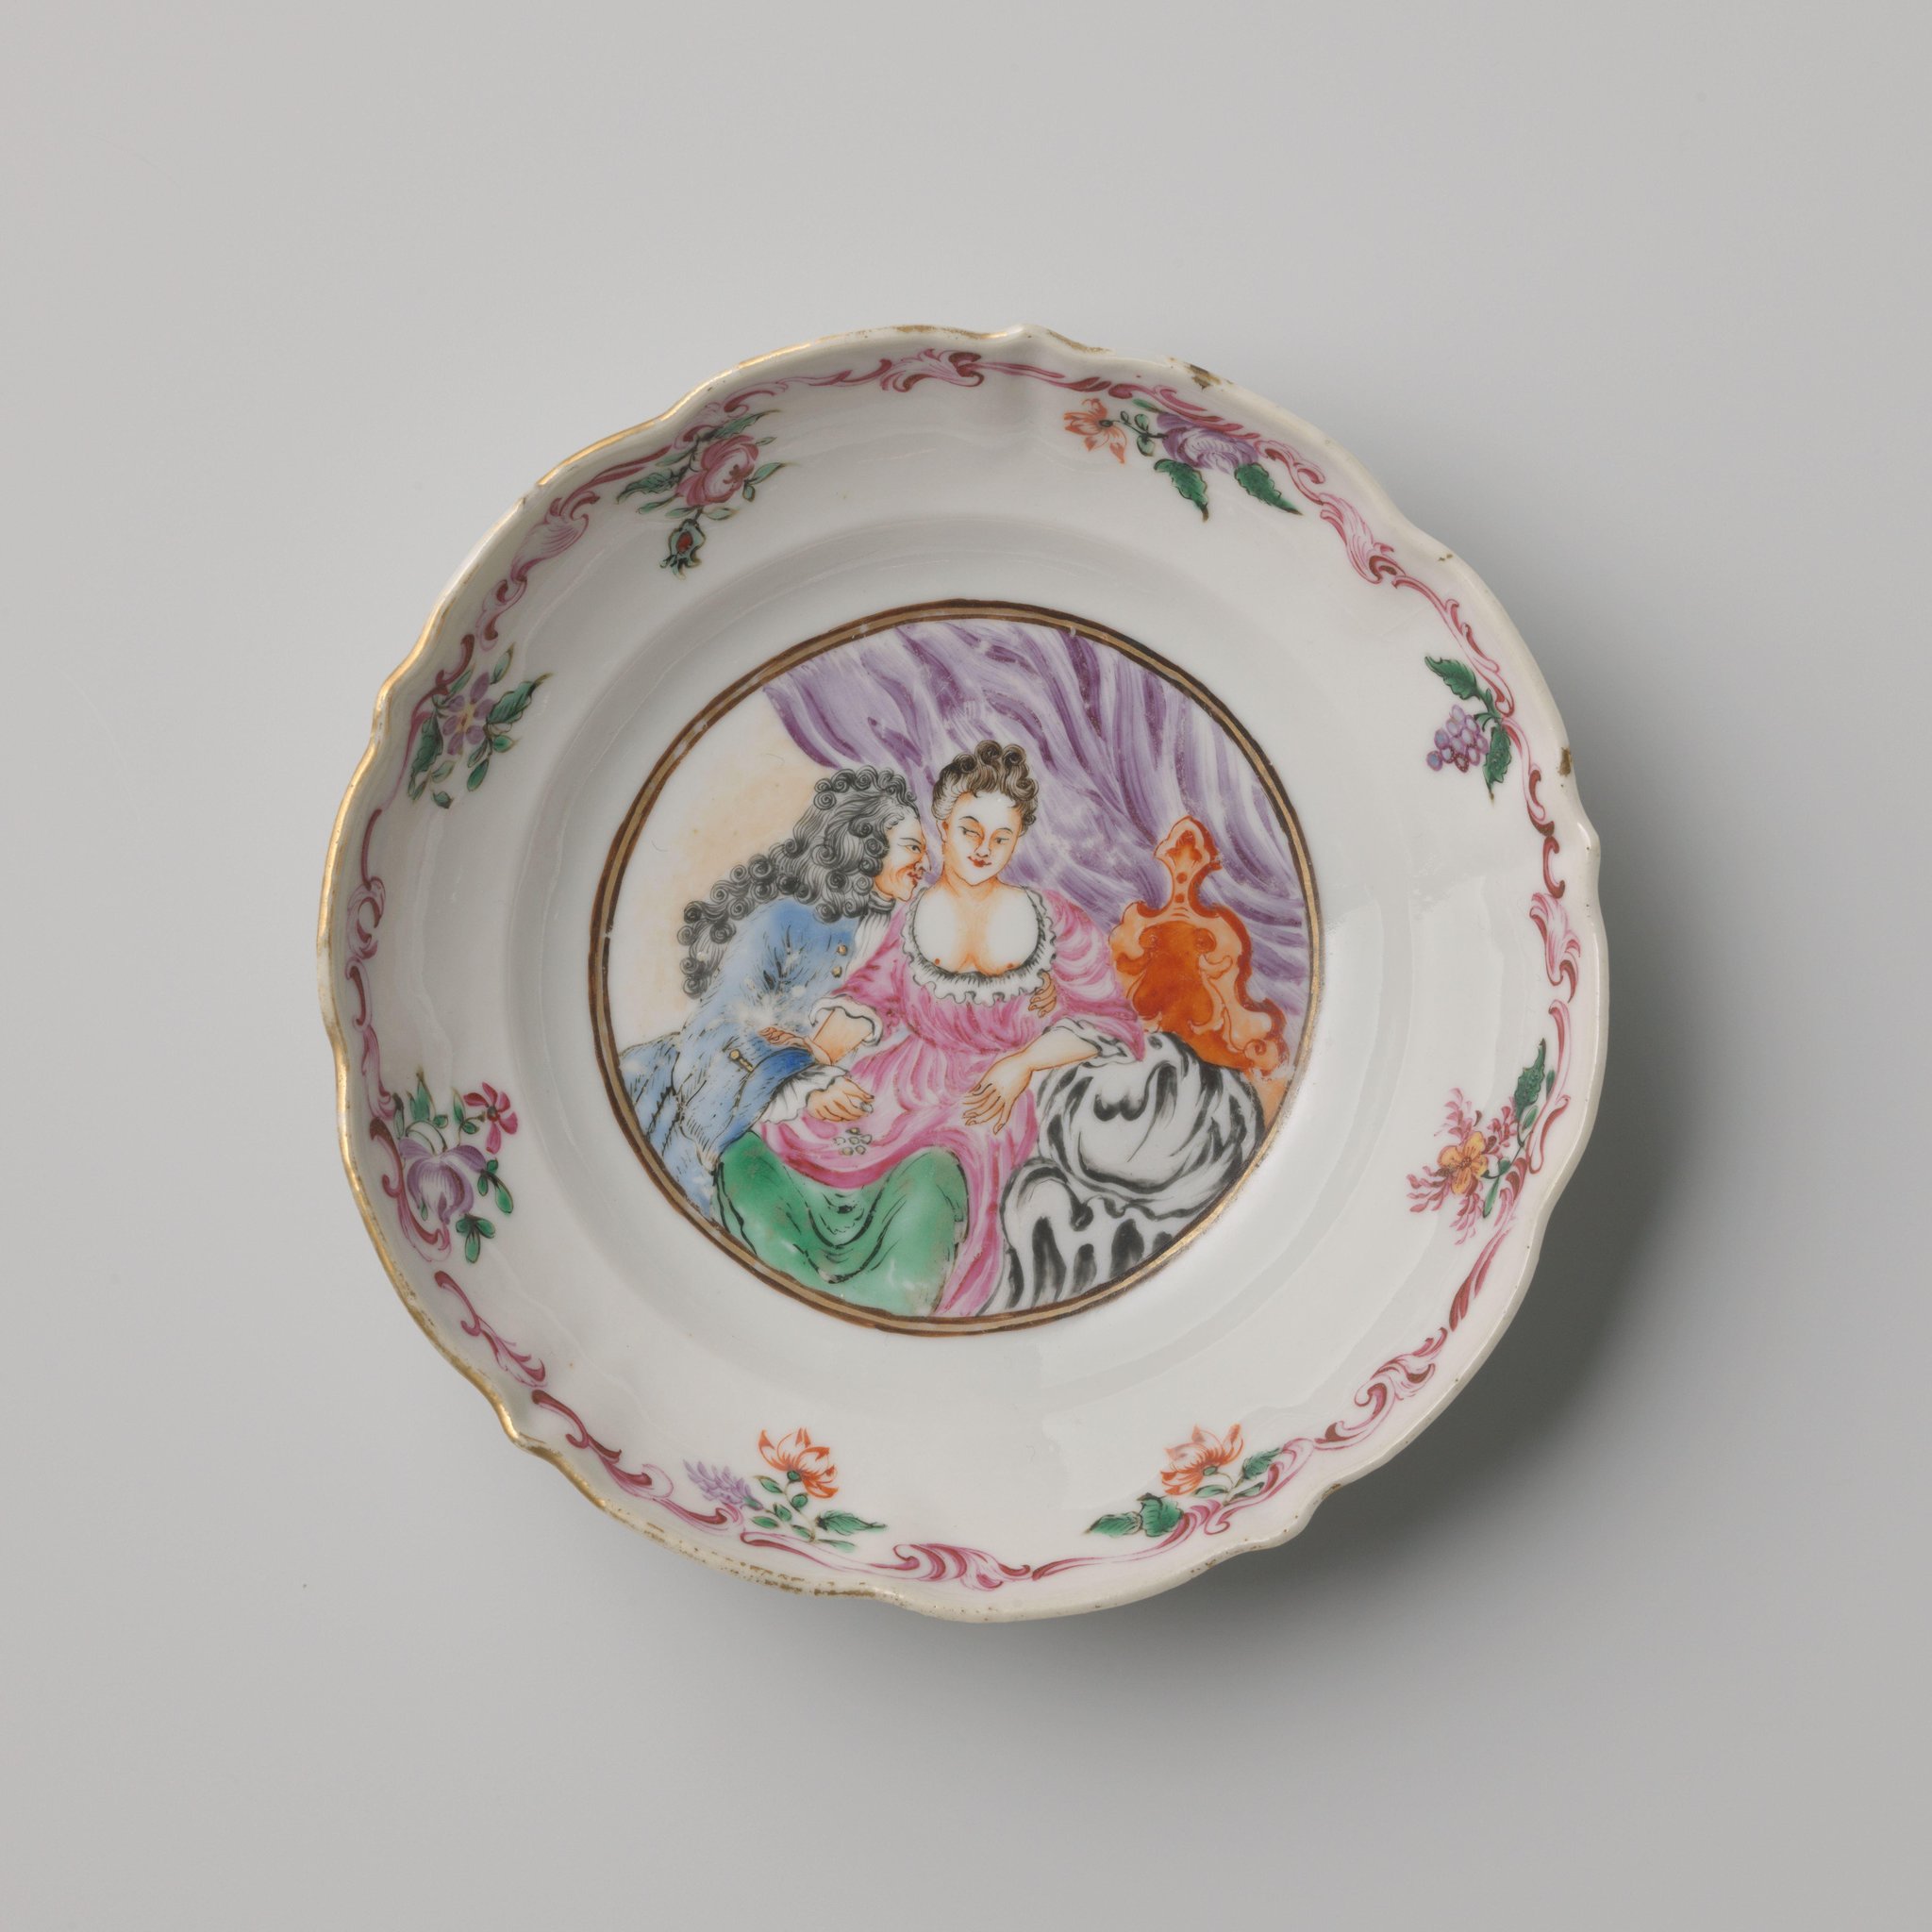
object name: platter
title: Saucer with a prostitute and man in an interior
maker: Anonymous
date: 1775-1799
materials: glaze, gold, paint, porcelain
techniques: firing, forming, gilding, turning, vitrification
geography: amsterdam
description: Kop en schotel op een voetring, met geschulpte rand. De kop bestaat uit twee secties, halverwege vertoont de kop een verwijding. Geschilderd in emailkleuren. Zowel op de kop als op de schotel bevinden zich een man en een vrouw, met op de achtergrond een gordijn. De man, links van de vrouw, draagt een pruik. De vrouw draagt een jurk met een diep decolleté. In haar schoot liggen een aantal munten. De voorstelling gaat terug op een prent van Bernard Picart (1673-1733) genaamd de Prostituée, vervaardigd in 1705. De dame wordt door de heer betaald voor haar diensten. Het populaire thema staat symbool voor de ongelijke liefde. De ongelijkheid kan worden uitgedrukt in leeftijd, in dit geval is het de man die betaalt voor de liefde. Bernard Picart, geboren in Frankrijk was zowel graveur als prentuitgever. Veel prenten van zijn hand, of veel van de door hem uitgegeven prenten zijn later geschilderd op Chinees porselein. Het betreft dan voornamelijk elegante, licht erotische scènes. Opvallend is dat voorstellingen op porselein bijzonder vaak in spiegelbeeld op de porseleinen voorwerpen werd aangebracht. In dat geval is een kopie van de prent als voorbeeld gebruikt. Ook deze voorstelling is zeer waarschijnlijk vervaardigd naar een kopie van de prent van Picart. De kopieën werden veelvuldig in Europa vervaardigd voor commercieel gebruik, en waren goedkoper dan de originele prenten.